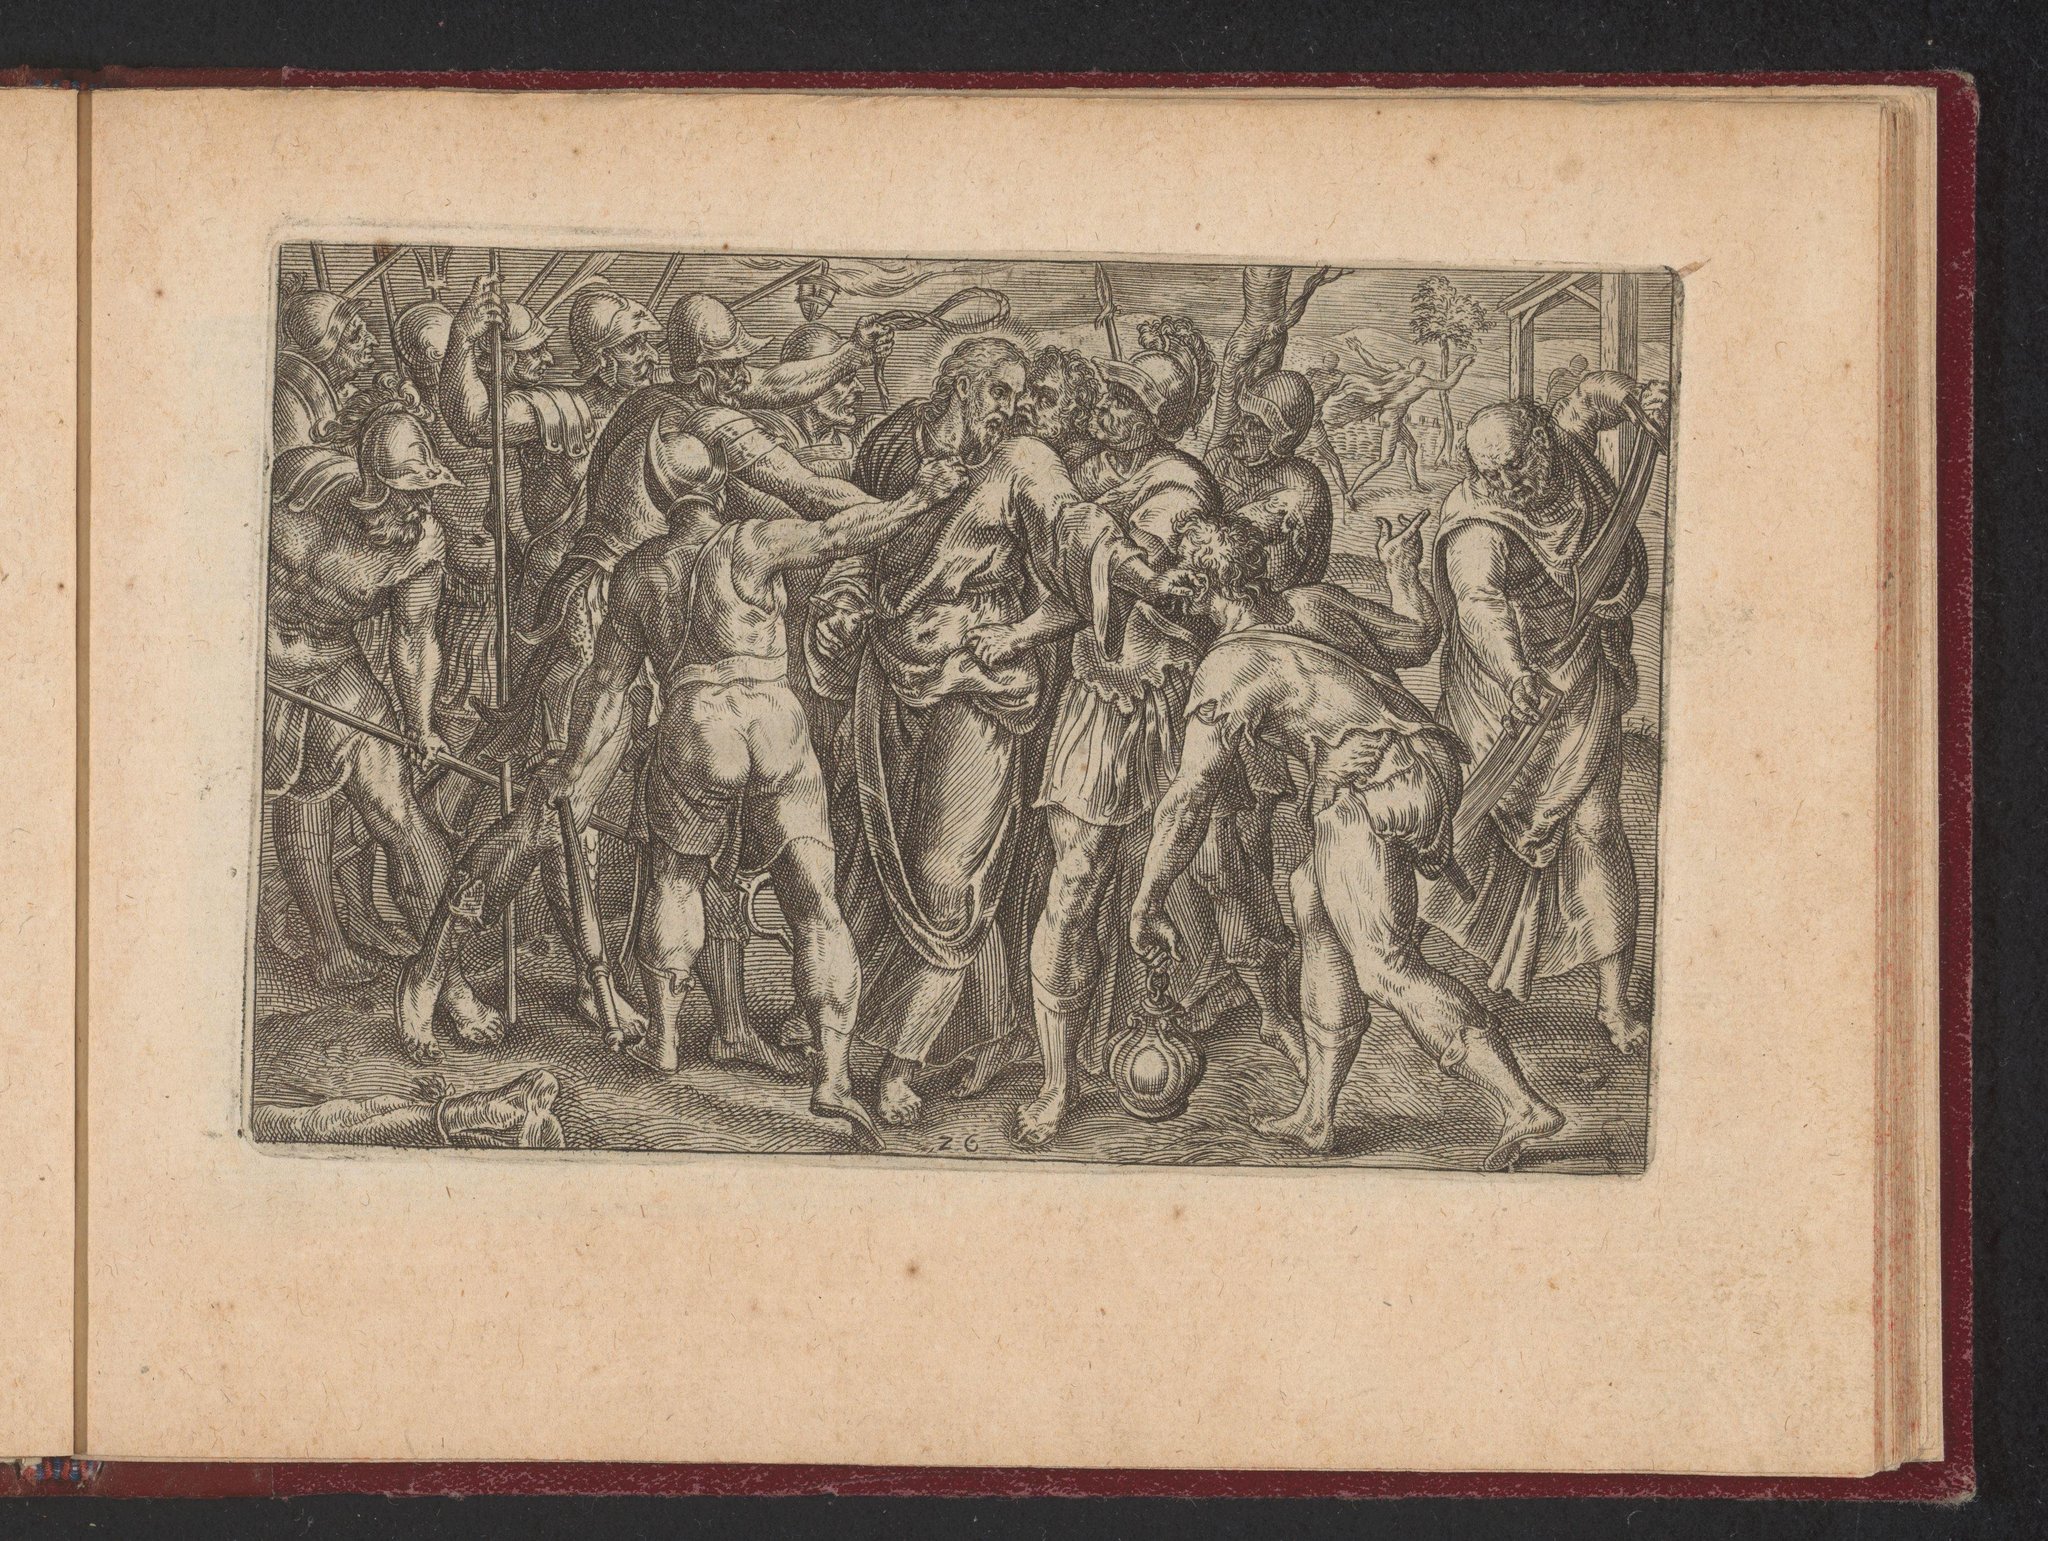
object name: print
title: Judaskus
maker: philips galle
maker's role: print maker, publisher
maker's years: 1537-1612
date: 1573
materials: paper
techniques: engraving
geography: antwerp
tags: the kiss of judas: accompanied by soldiers with torches and lanterns, he kisses christ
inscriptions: watermark: ‘gotische letter P’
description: Onderdeel van een album met een titelprent en een serie van 50 prenten betreffende het leven en de passie van Christus.